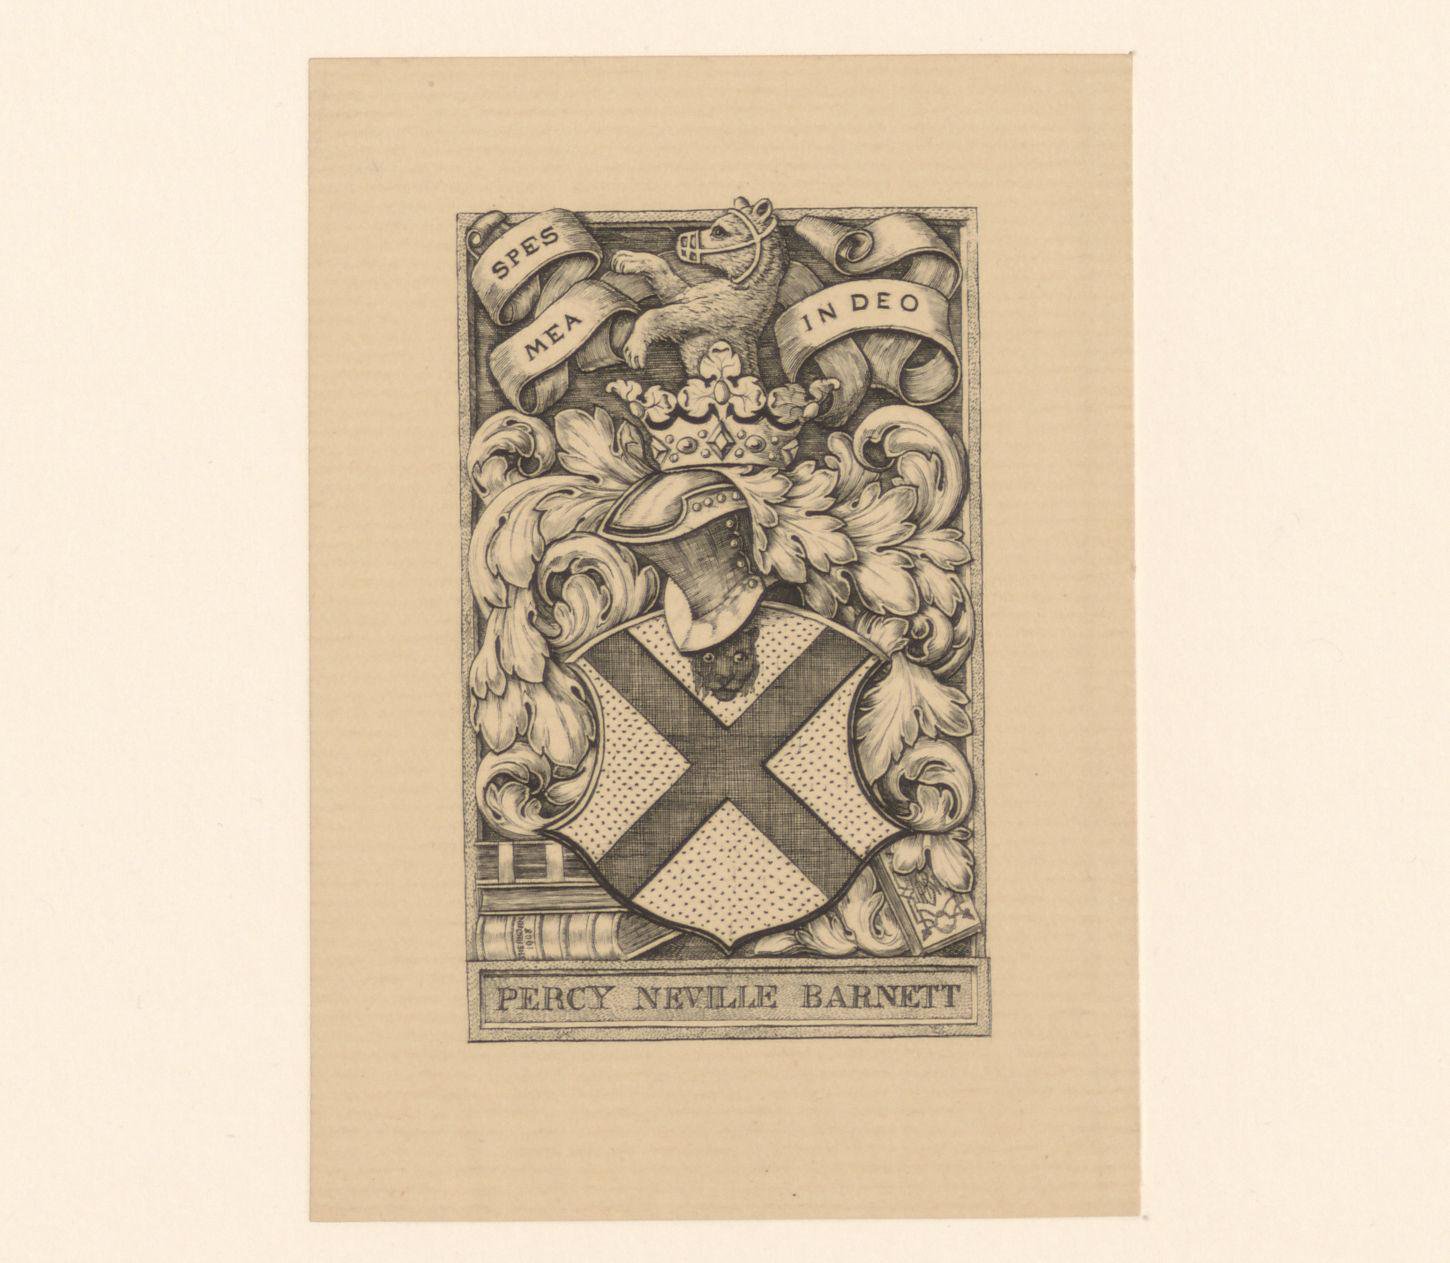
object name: bookplate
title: Spes mea in deo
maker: charles william sherborn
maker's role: print maker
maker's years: 1831-1912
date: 1908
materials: paper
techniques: engraving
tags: foliage ~ ornament, beasts of prey, predatory animals: bear, book, armorial bearing, heraldry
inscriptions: collector's mark: Lugt 2228